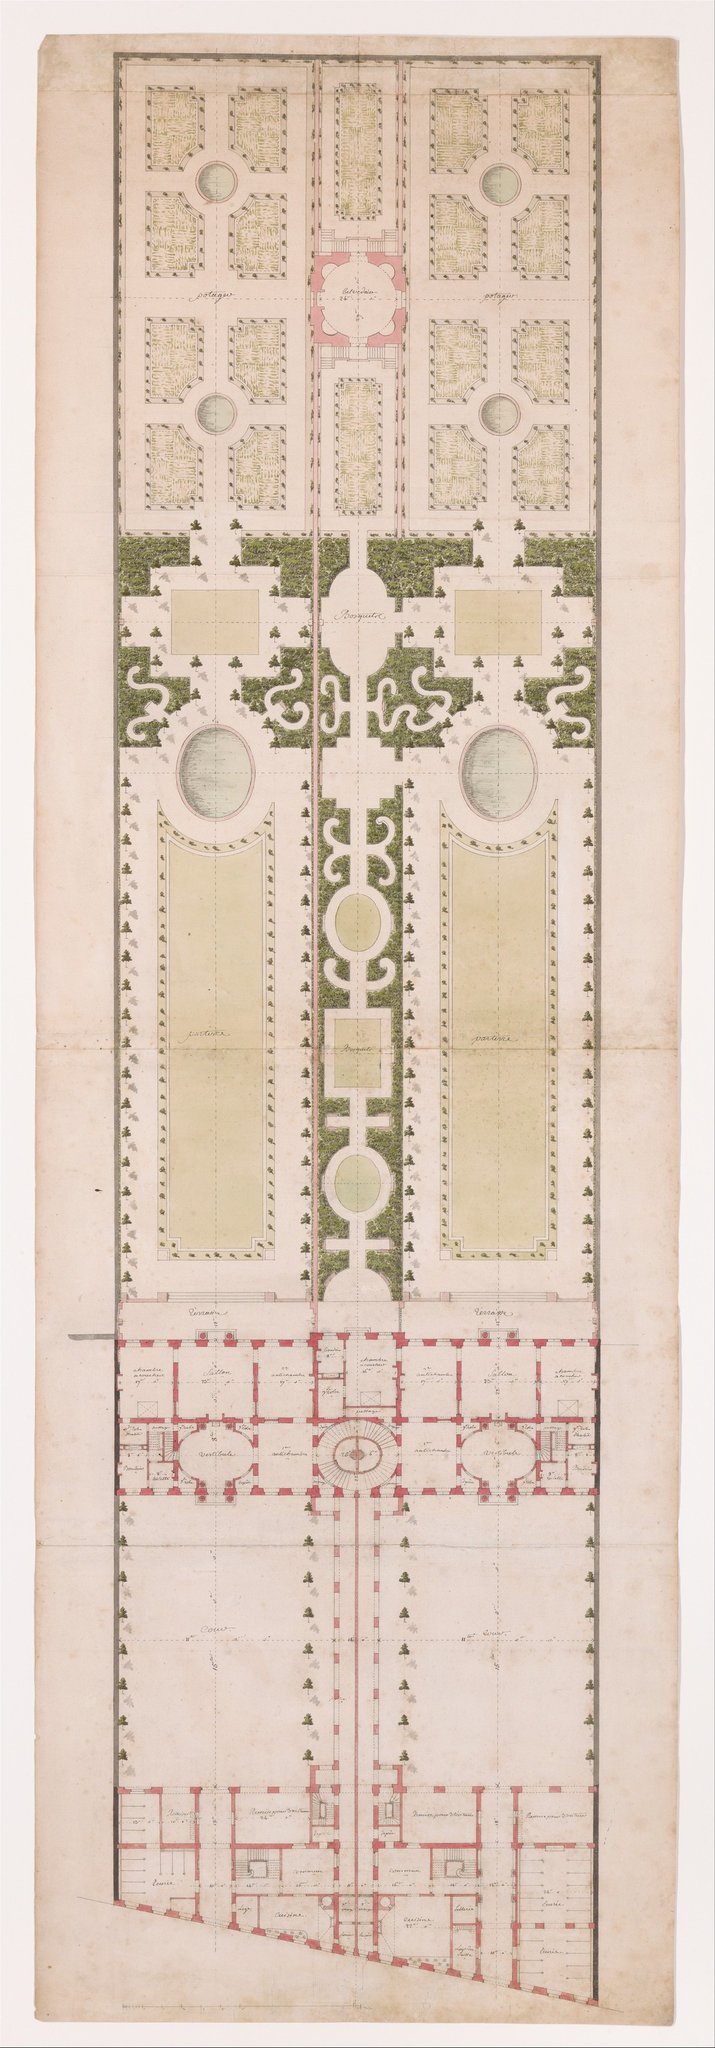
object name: drawing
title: Ground Plan for the Hotel de la Rochefoucauld Doudeauville and its Garden, Paris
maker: jean jacques huvé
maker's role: artist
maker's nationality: french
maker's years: 1742-1808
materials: graphite, ink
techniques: pen, drawing, wash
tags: architecture,gardens